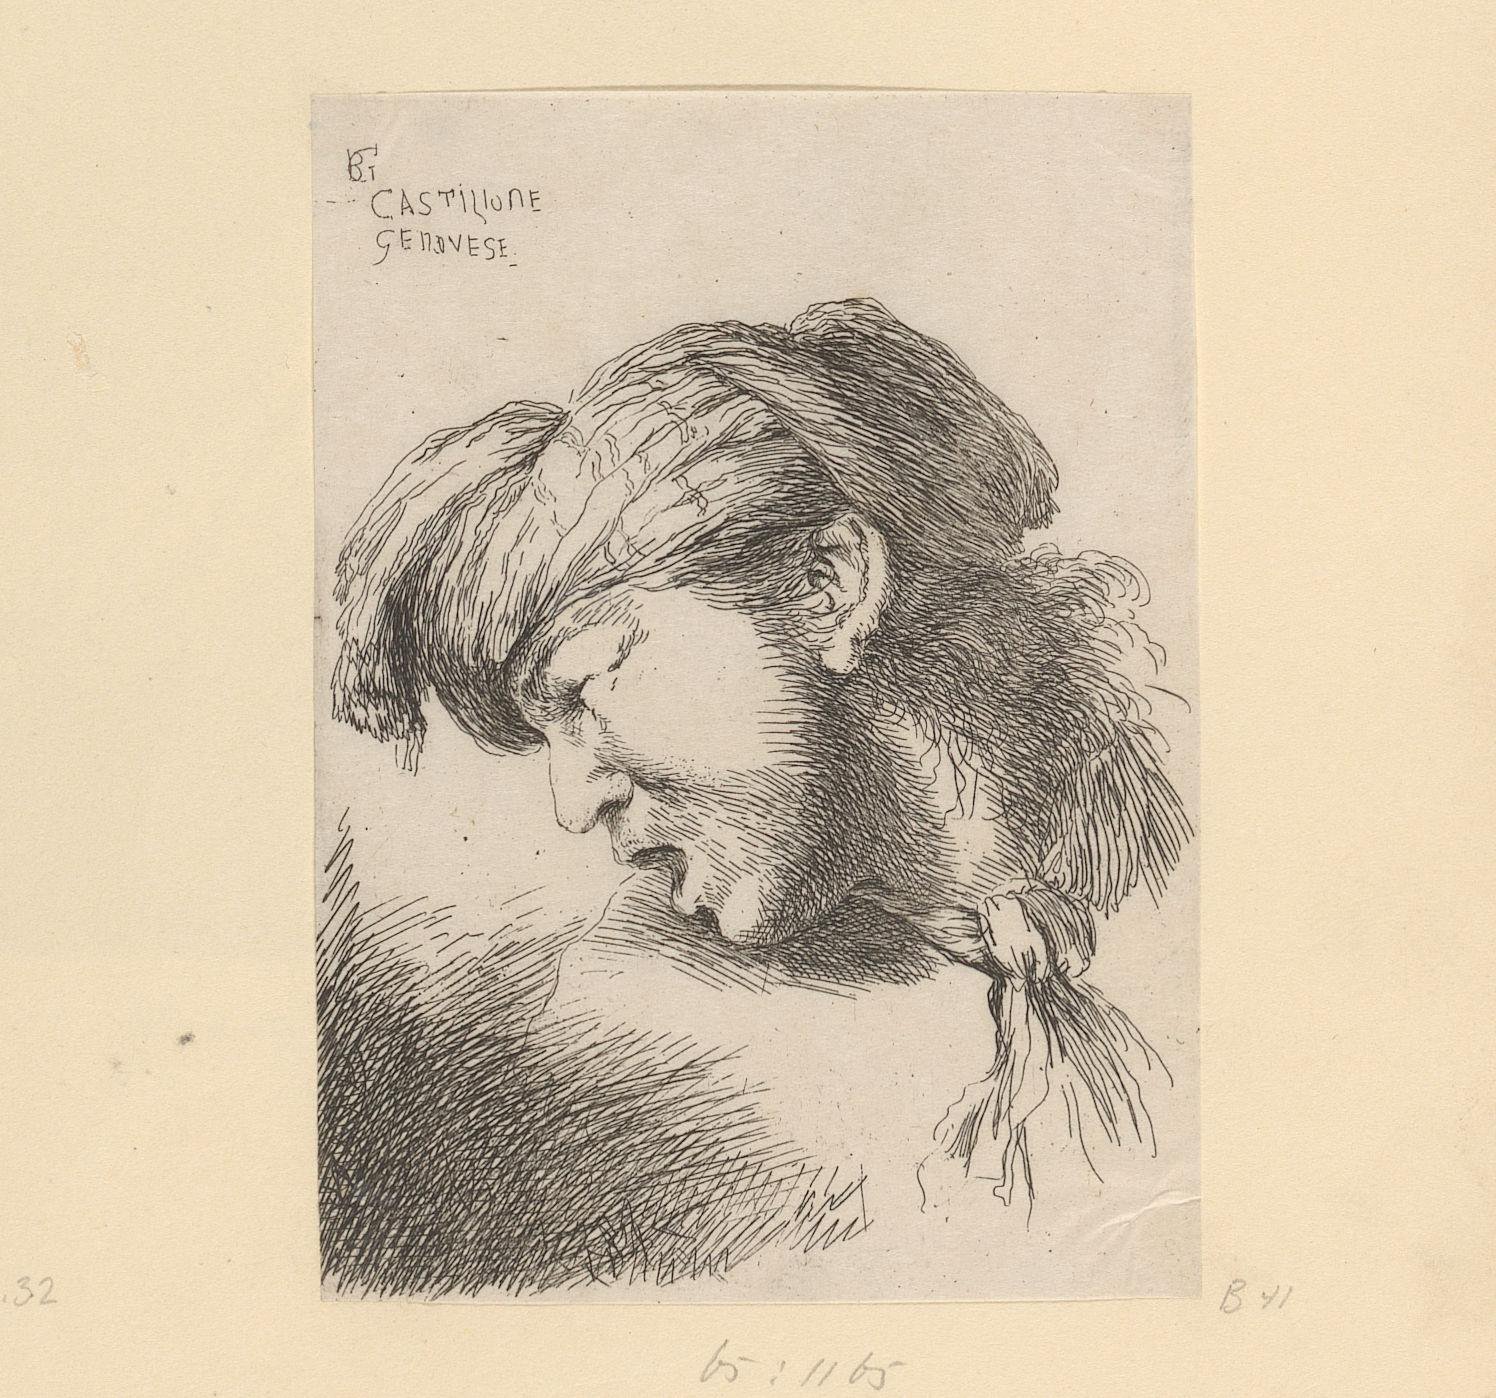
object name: album leaf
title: Kleine studie van hoofden met oosterse hoofddeksels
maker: giovanni benedetto castiglione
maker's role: draughtsman, print maker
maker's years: 1610-1665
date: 1645-1650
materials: paper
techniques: etching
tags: head (human), head-gear: turban (+ men's clothes)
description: Prent is onderdeel van een serie van zestien prenten. Prent maakt mogelijk deel uit van een serie van 200 prenten. Deze serie is onder de titel 'A Collection of two hundred original etchings' voor het eerst uitgegeven door J.M. Greery in 1816.